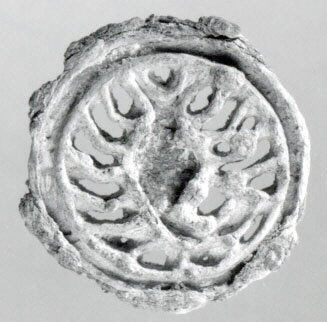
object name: stamp seal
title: Compartmented stamp seal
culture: bactria-margiana archaeological complex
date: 2333-1668 BCE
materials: copper alloy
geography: bactria-margiana